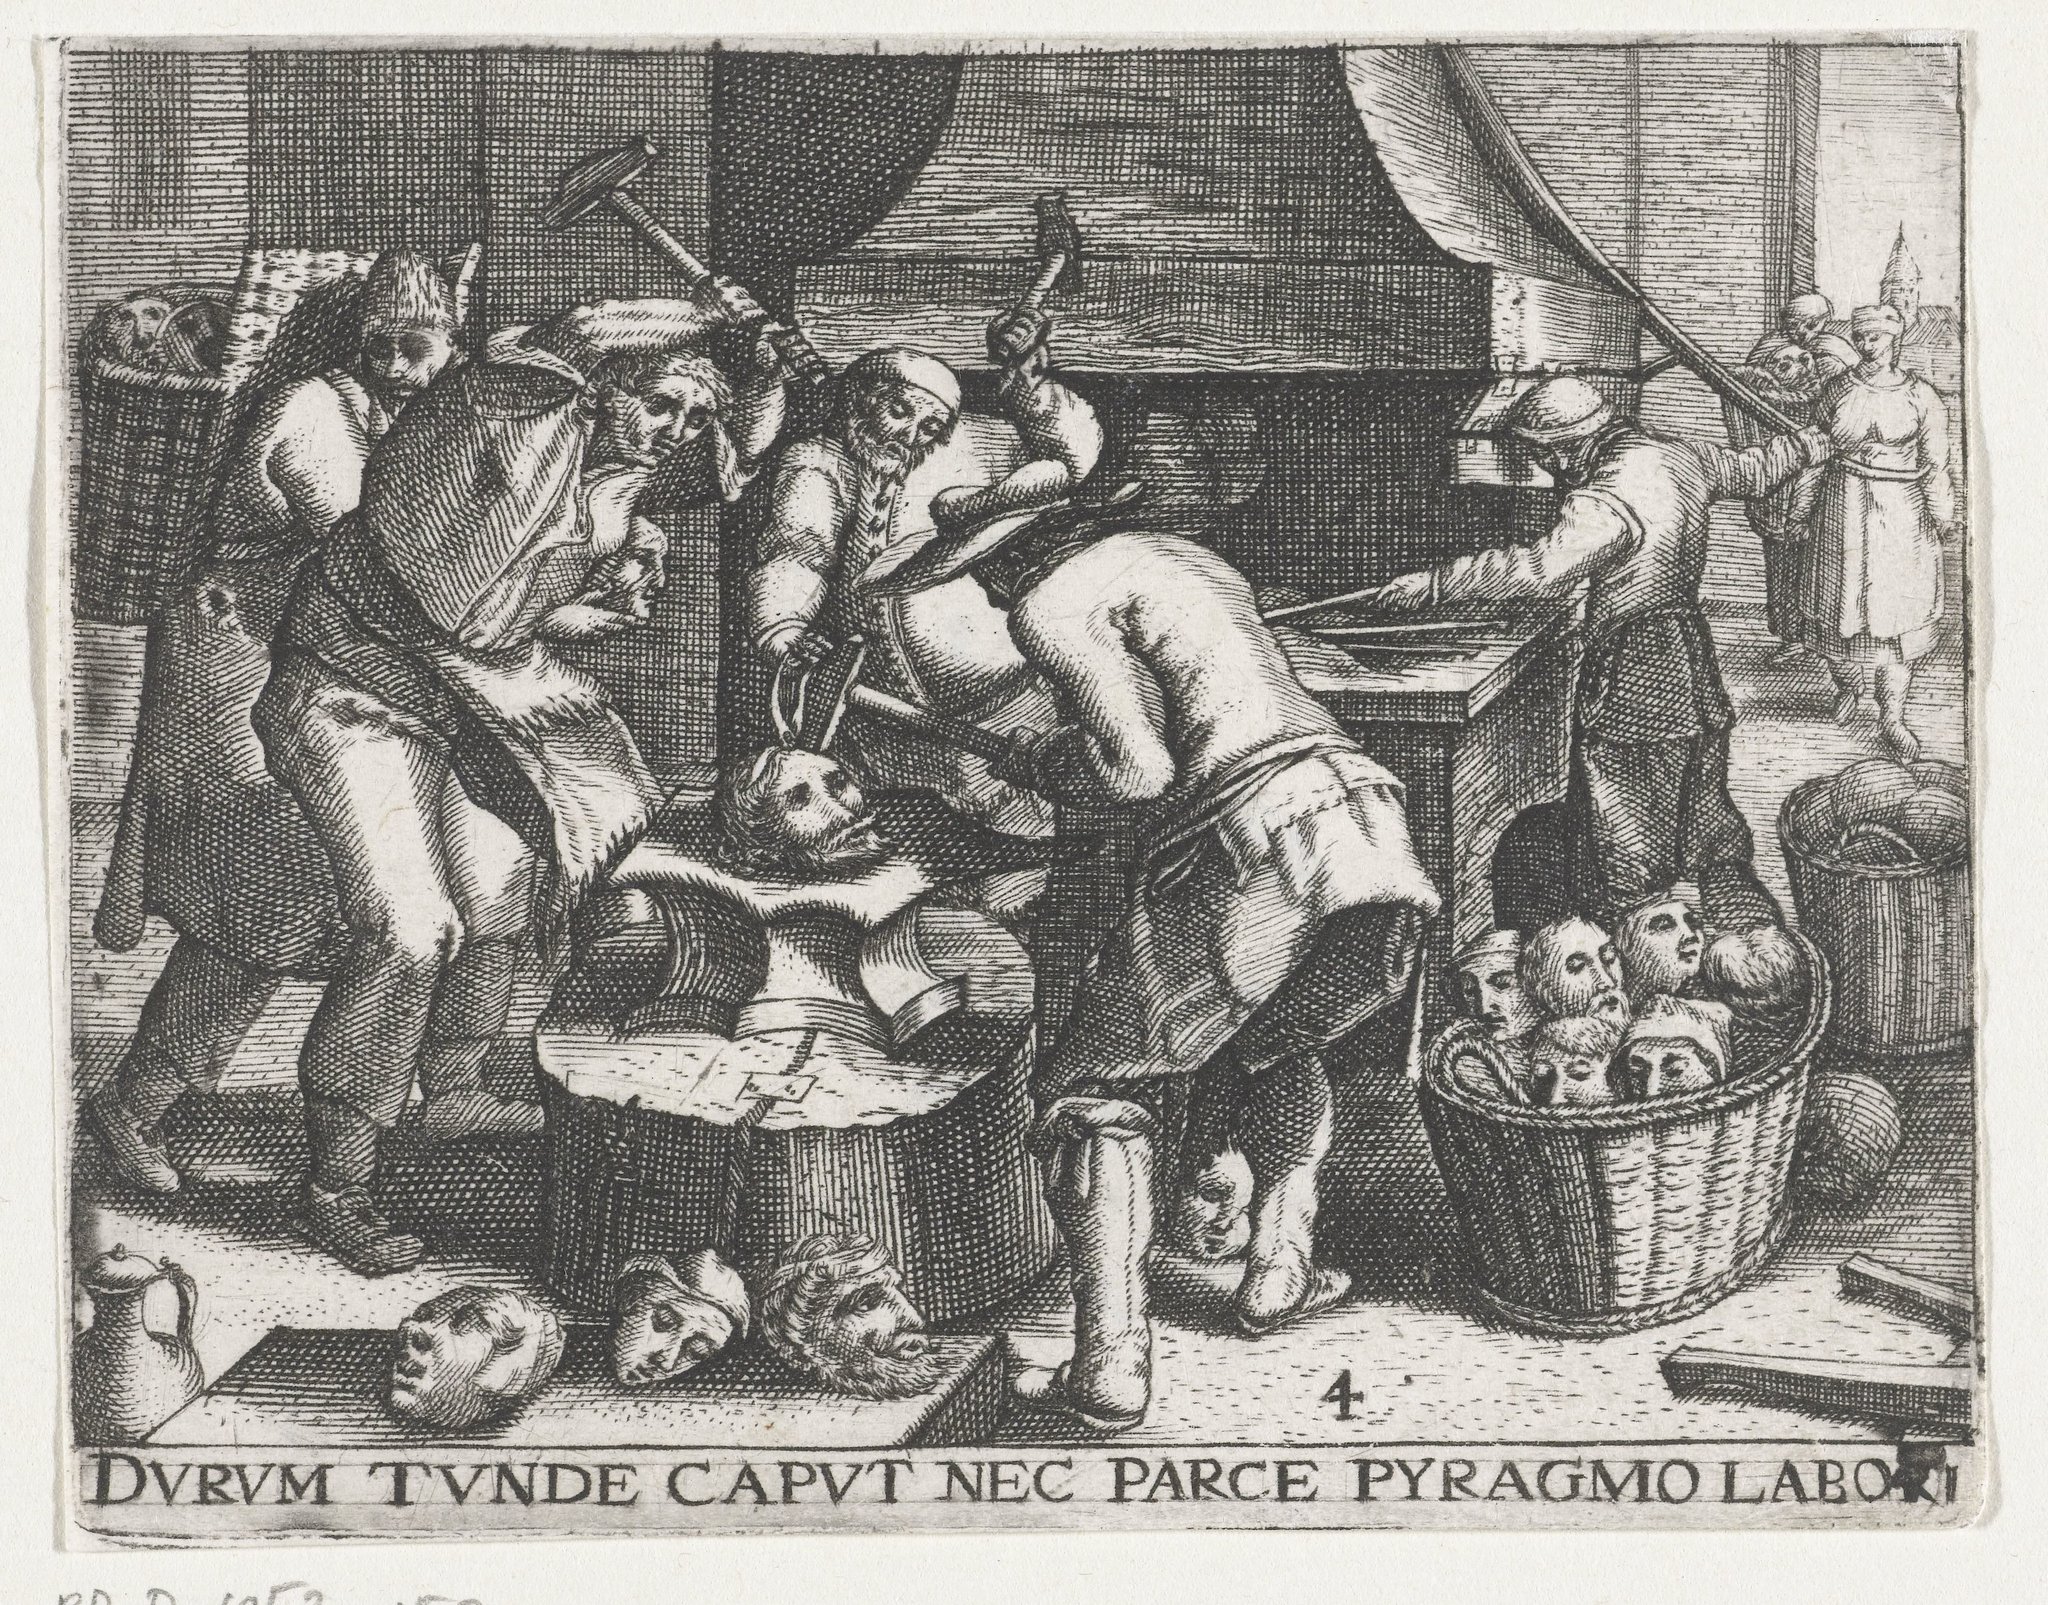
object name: book illustration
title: Emblemata Saecularia, 1611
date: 1611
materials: paper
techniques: engraving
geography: oppenheim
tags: abstract ideas and concepts (+ emblematical representation of concept), ways pretending to cure simpletons (folklore), forging (industrial process) (+ variant), obstinacy; 'ostinatione', 'pertinacia' (ripa)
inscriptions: collector's mark: Lugt 2398, collector's mark: Lugt 1606, collector's mark: Lugt 2228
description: In een smederij worden menselijke hoofden gesmeed. Het zijn "harde koppen" die op een halsstarrige en trotse houding wijzen. De ondeugd van de halsstarrigheid kan alleen worden veranderd door de "spijtige herde bollen" om te smeden. Het zijn er zo veel en ze zijn zo alom tegenwoordig dat de smeden waarschijnlijk eeuwig met deze arbeid bezig zullen zijn. Het bijbehoren epigram meldt: Maer al deden wy t'ambacht reuwich met pyne / Noch sal men over al in Landen end'steden / Qua hoofden ghenoech vinden t'allen termyne. Embleem no. 4 uit Emblemata Saecularia, 1611